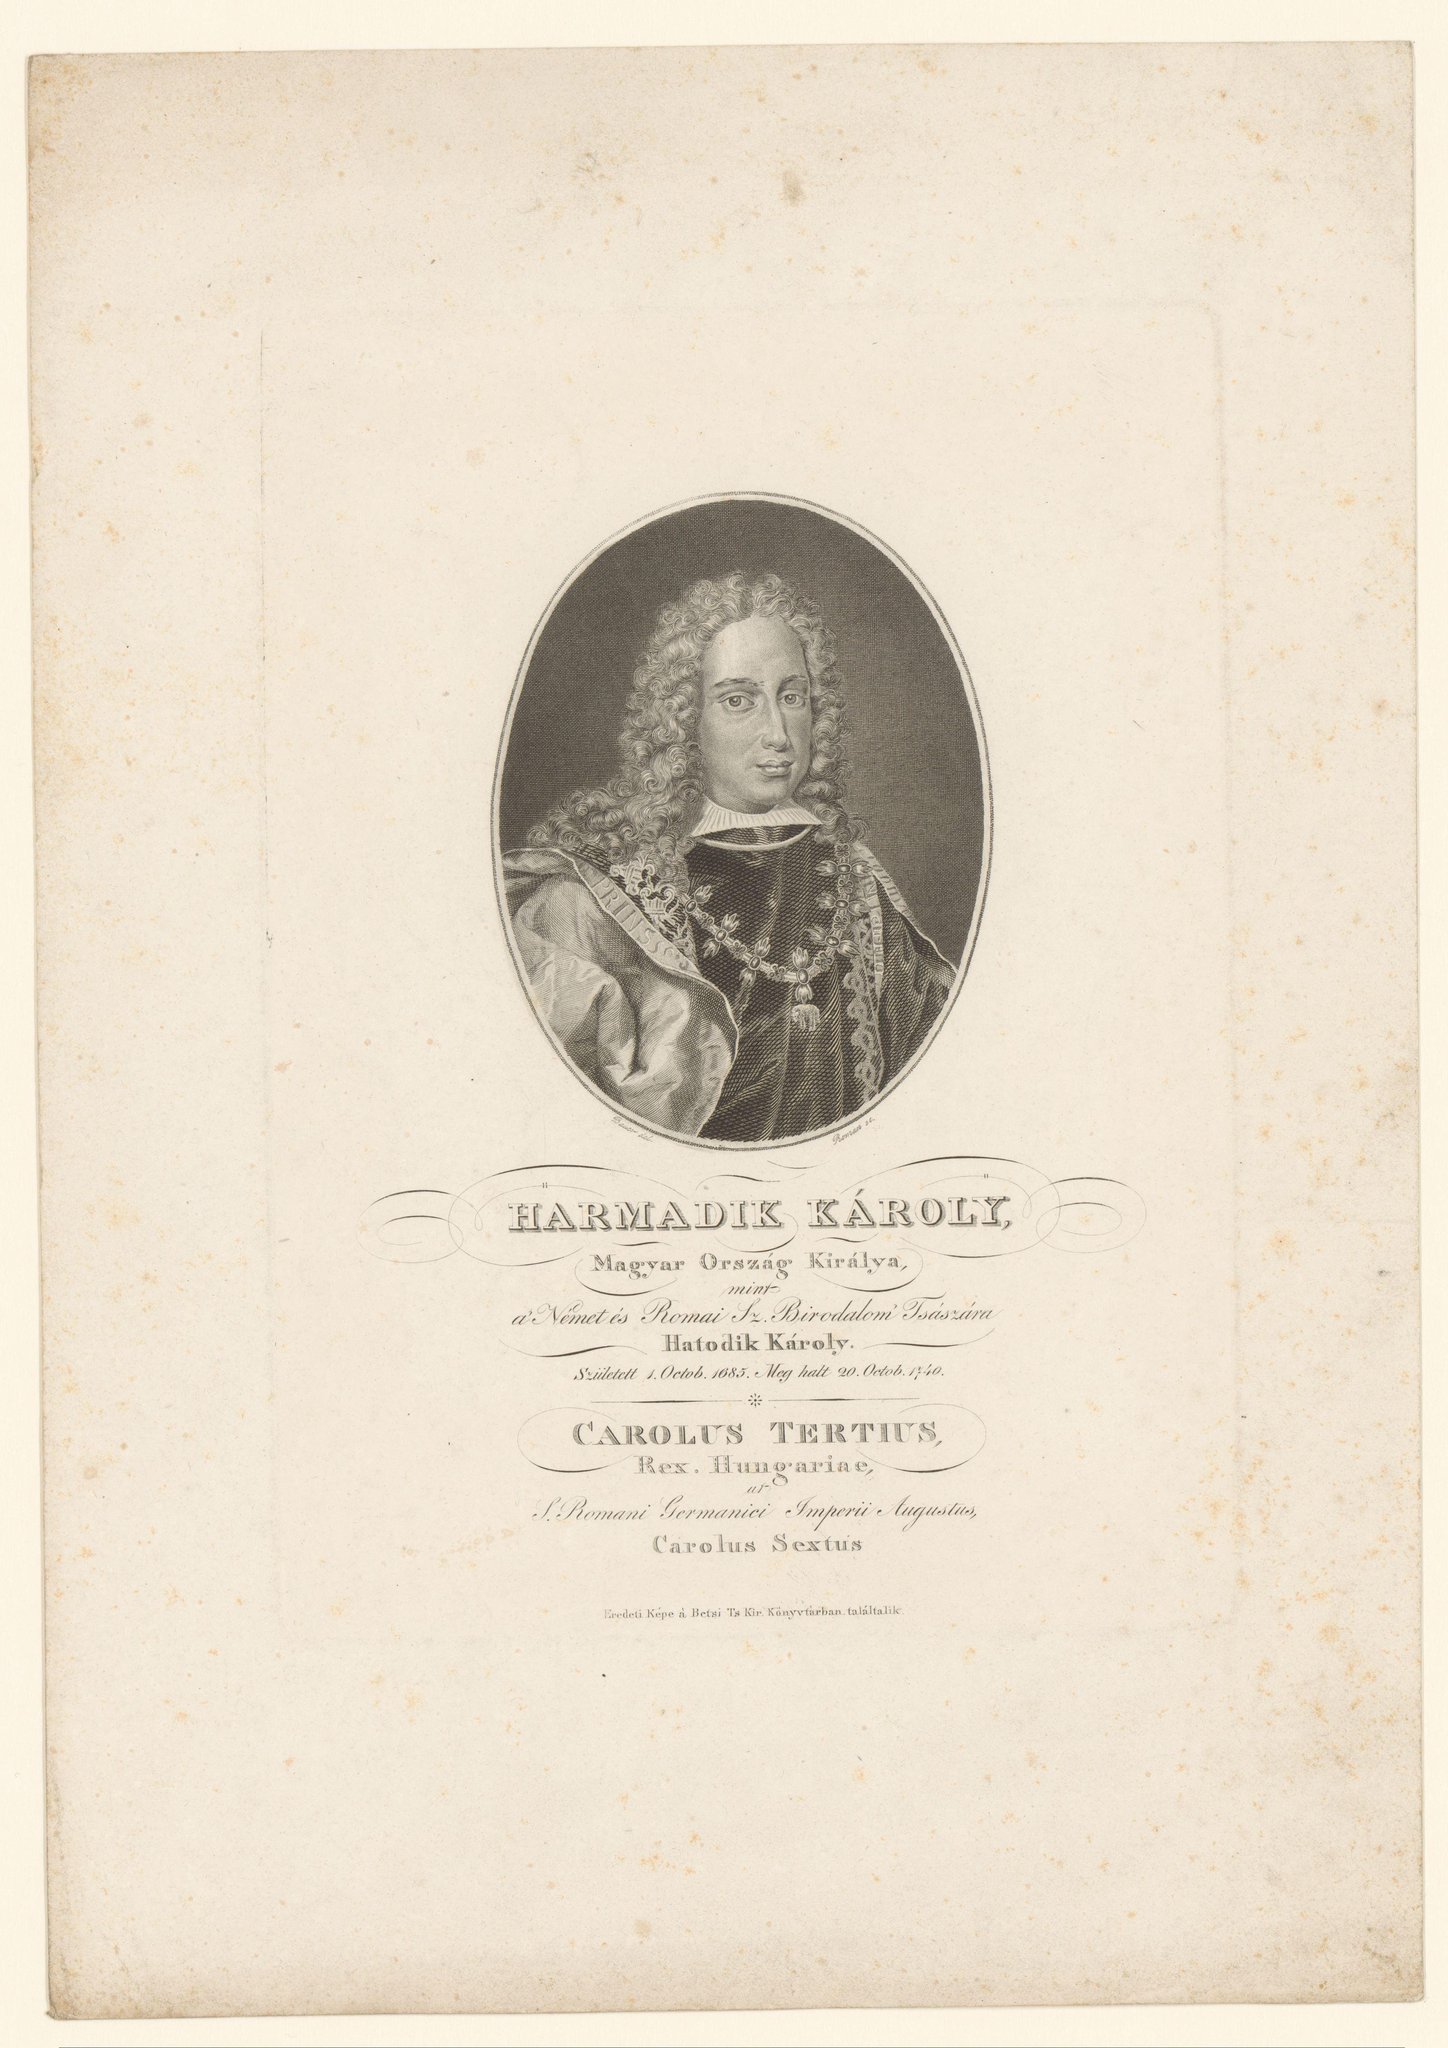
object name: print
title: Portret van keizer Karel VI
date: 1700-1799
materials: paper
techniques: engraving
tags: vienna, charles vi (holy roman emperor), historical persons, knighthood order of the golden fleece - insignia of a knighthood order, e.g.: badge, chain (with name of order)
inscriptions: collector's mark: Lugt 2228